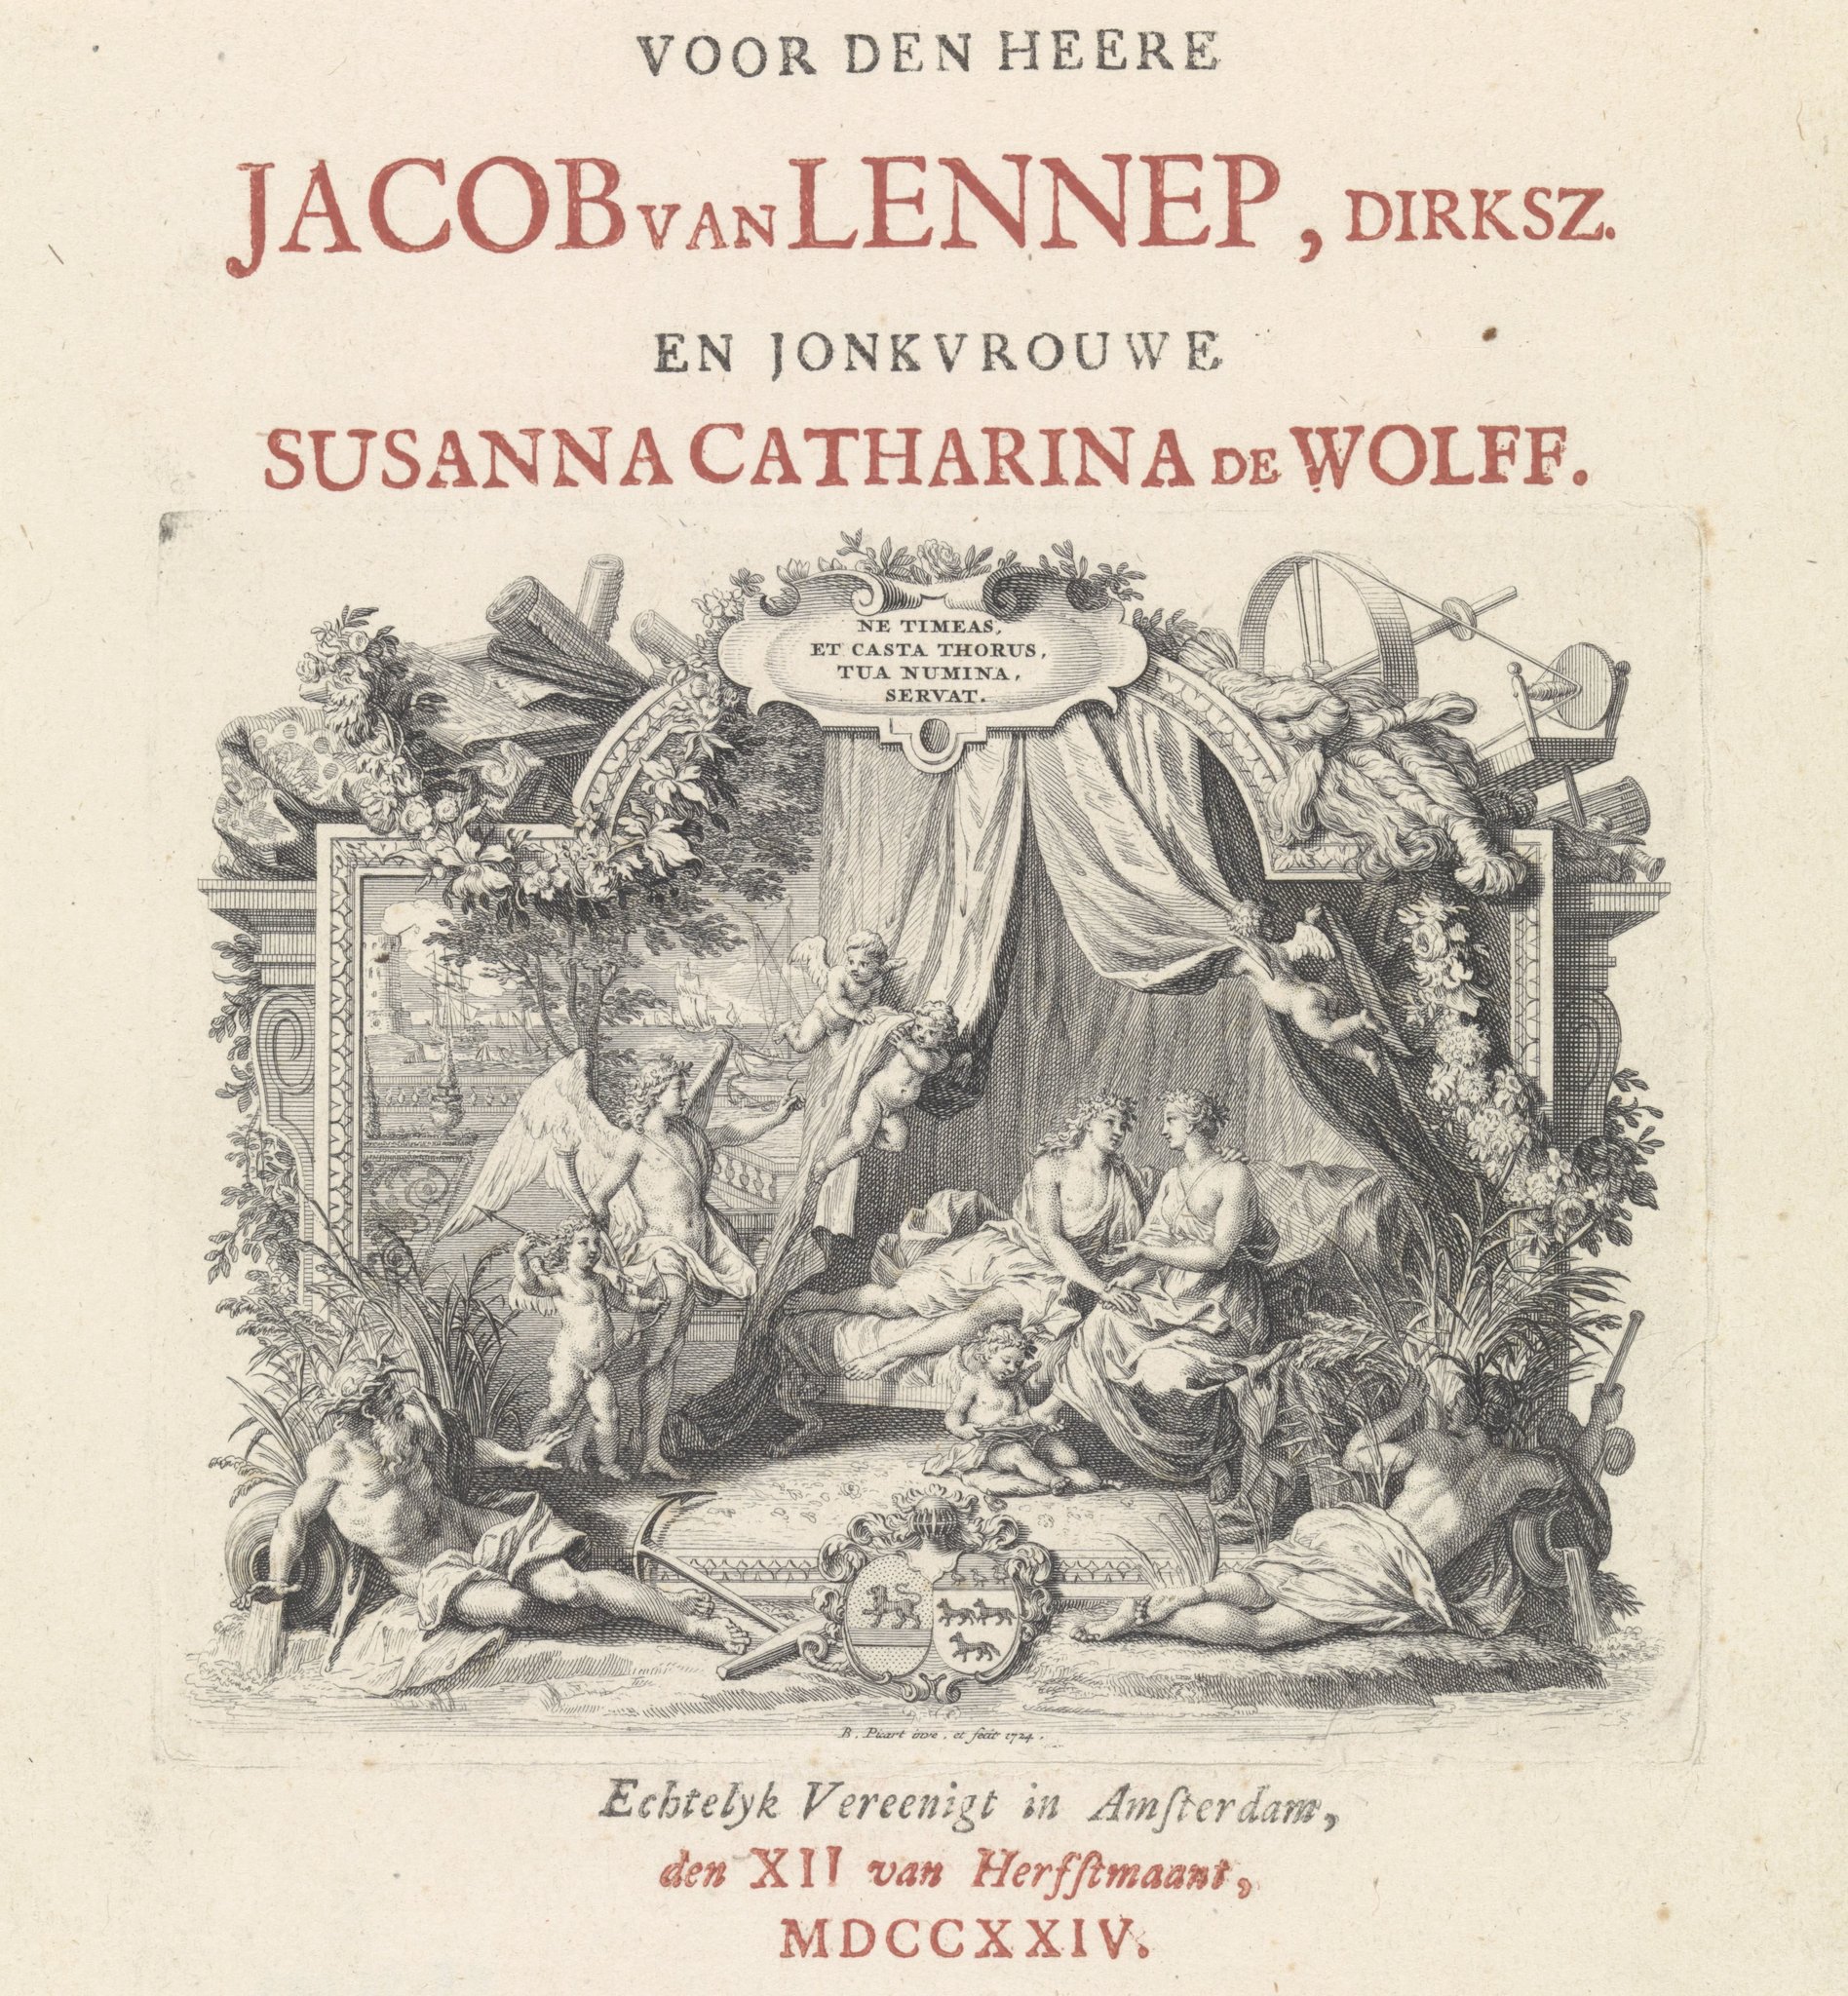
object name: print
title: Allegorische voorstelling ter gelegenheid van het huwelijk van Jacob Dircksz van Lennep en Susanna Catharina de Wolff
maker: bernard picart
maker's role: draughtsman, print maker, publisher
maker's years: 1673-1733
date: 1724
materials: paper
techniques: engraving, etching, letterpress printing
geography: amsterdam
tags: (story of) hymen(aeus), river-gods, marriage, married couple, 'matrimonium', (story of) cupid, amor (eros)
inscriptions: collector's mark: Lugt 240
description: Allegorische voorstelling ter gelegenheid van het huwelijk van Jacob Dircksz van Lennep en Susanna Catharina de Wolff in 1724 te Amsterdam. De huwelijksgod Hymen en Amor bij het huwelijksbed van het paar. Rechts de stroomgod van het IJ en links de waternimf van de Amstel. Boven de voorstelling stoffen, een spinnewiel en het devies: Ne Timeas et Casta Thorus Tua Numina Servat.